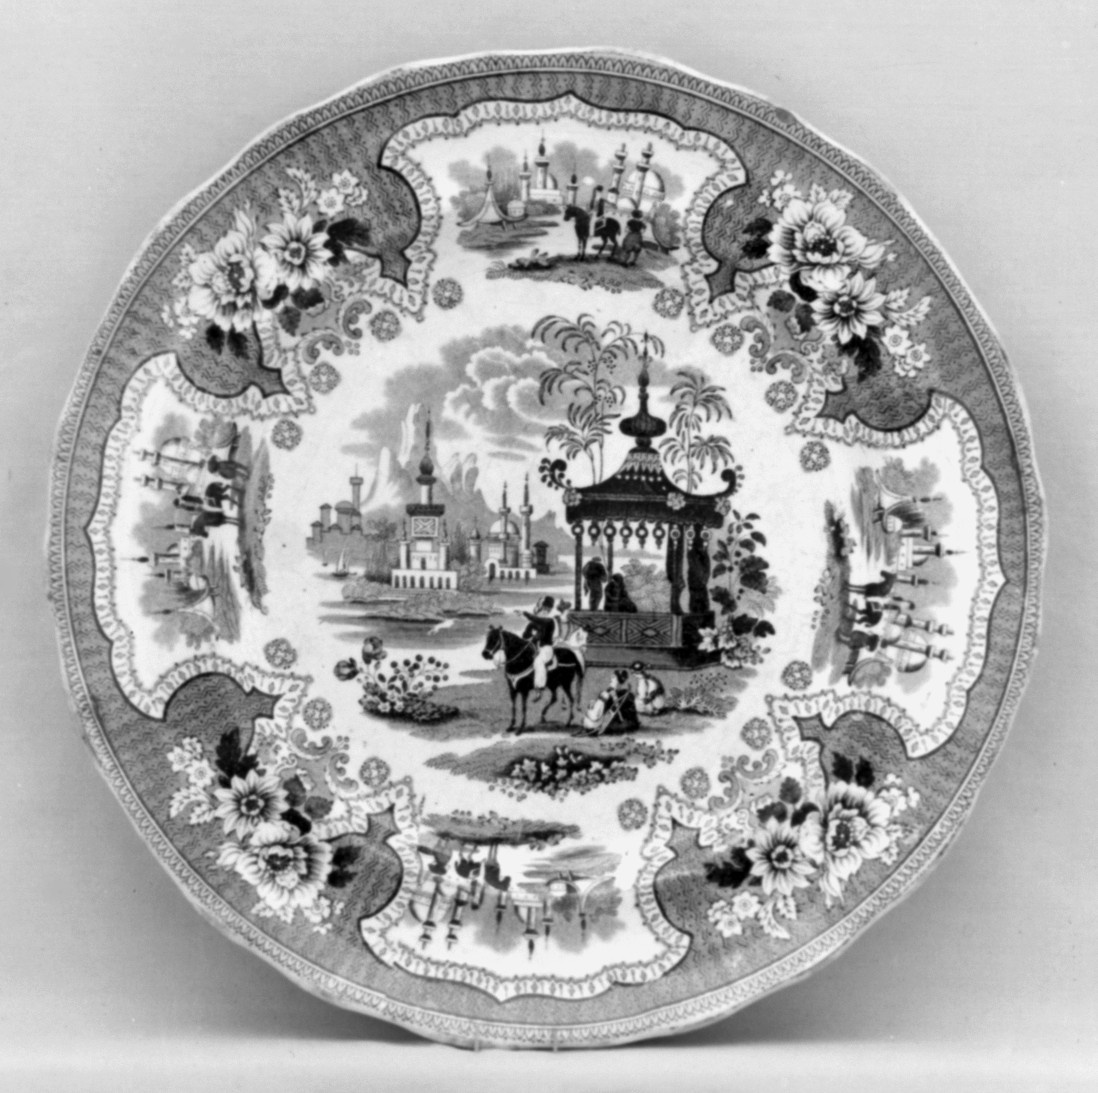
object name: plate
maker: william adams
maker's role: maker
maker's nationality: british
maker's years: 1798-1865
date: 1801-1900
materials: pottery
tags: buildings,men,horses,flowers